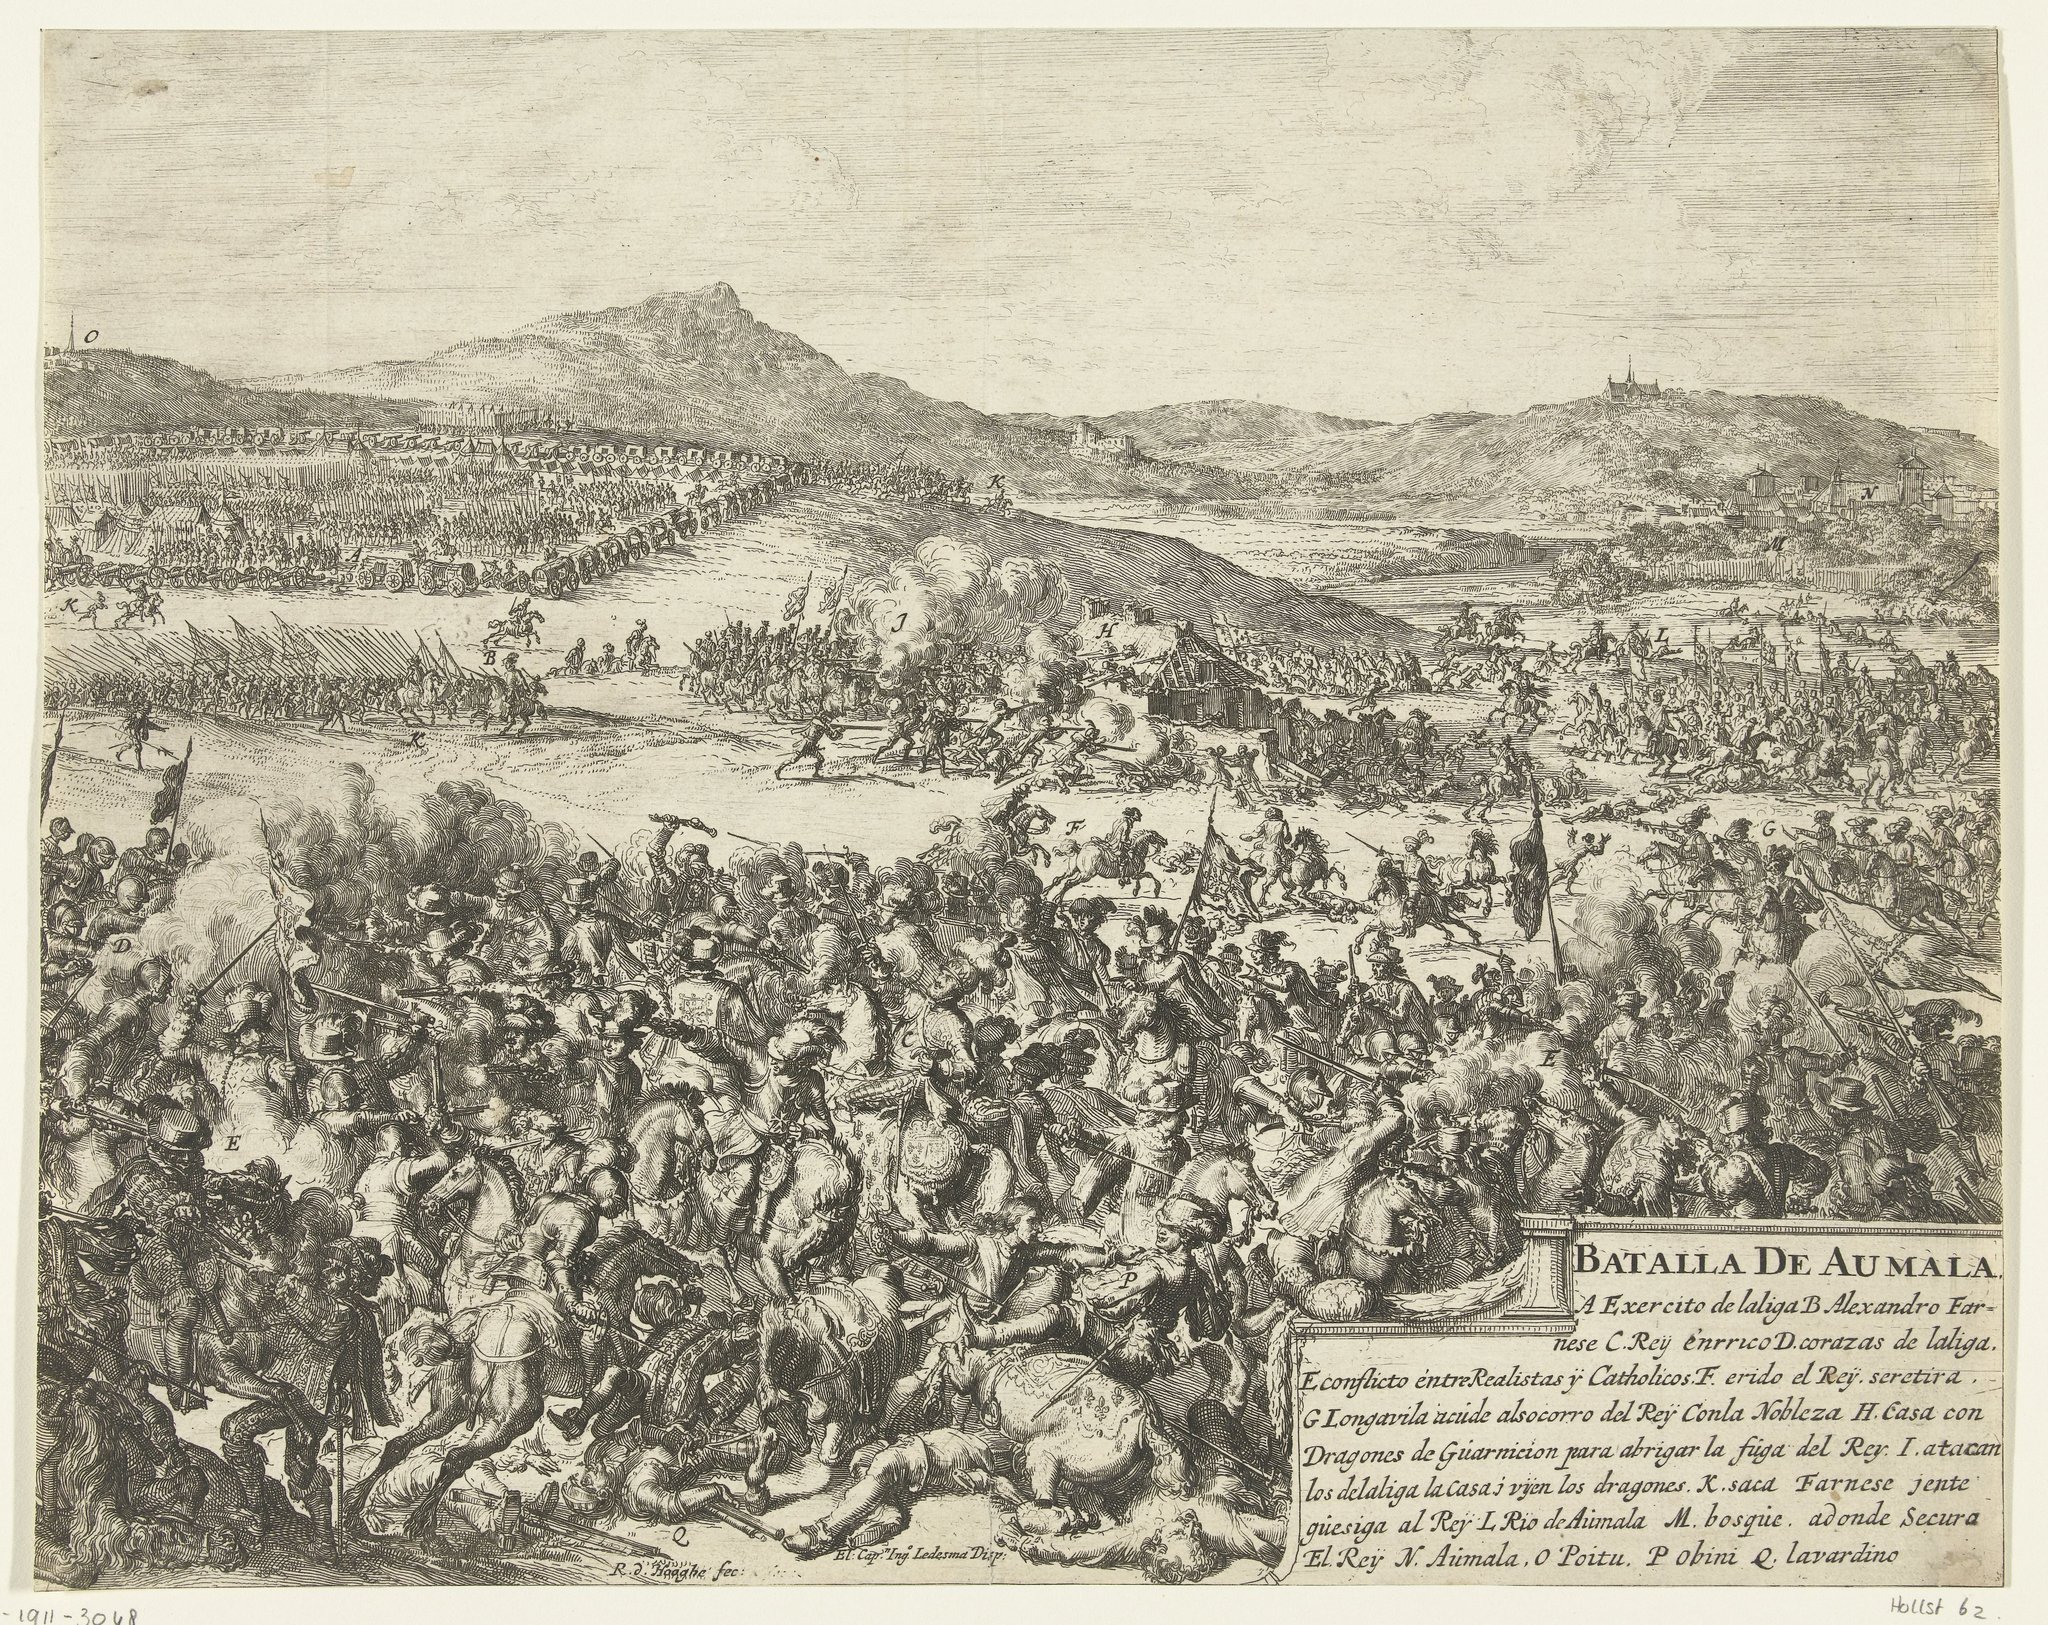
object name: print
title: Slag bij Aumale, 1592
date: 1670-1699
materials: paper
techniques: engraving, etching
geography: netherlands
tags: rome, alessandro farnese (landvoogd van de nederlanden en hertog van parma en piacenza), hendrik iv (koning van frankrijk en navarra), battle, fighting in general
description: Waarschijnlijk oorspronkelijk vervaardigd voor een uitgave van Histoire de la guerre de Flandre, van F. Strada, eind 17e eeuw. De prent is onderdeel van een bundel van prenten en portretten getiteld Des Guerres de Flandres, in drie delen, met in totaal 22 batailles, 6 portretten en 3 titelprenten voor de afzonderlijke delen, alles (behalve de portretten) door De Hooghe en Ledesma in één band, ongenummerd en zonder titelblad (zie Rijksmuseum Research Library, inv.nr. BI-1929-10, 329 C 20). De prenten hebben betrekking op de periode 1567-1592.